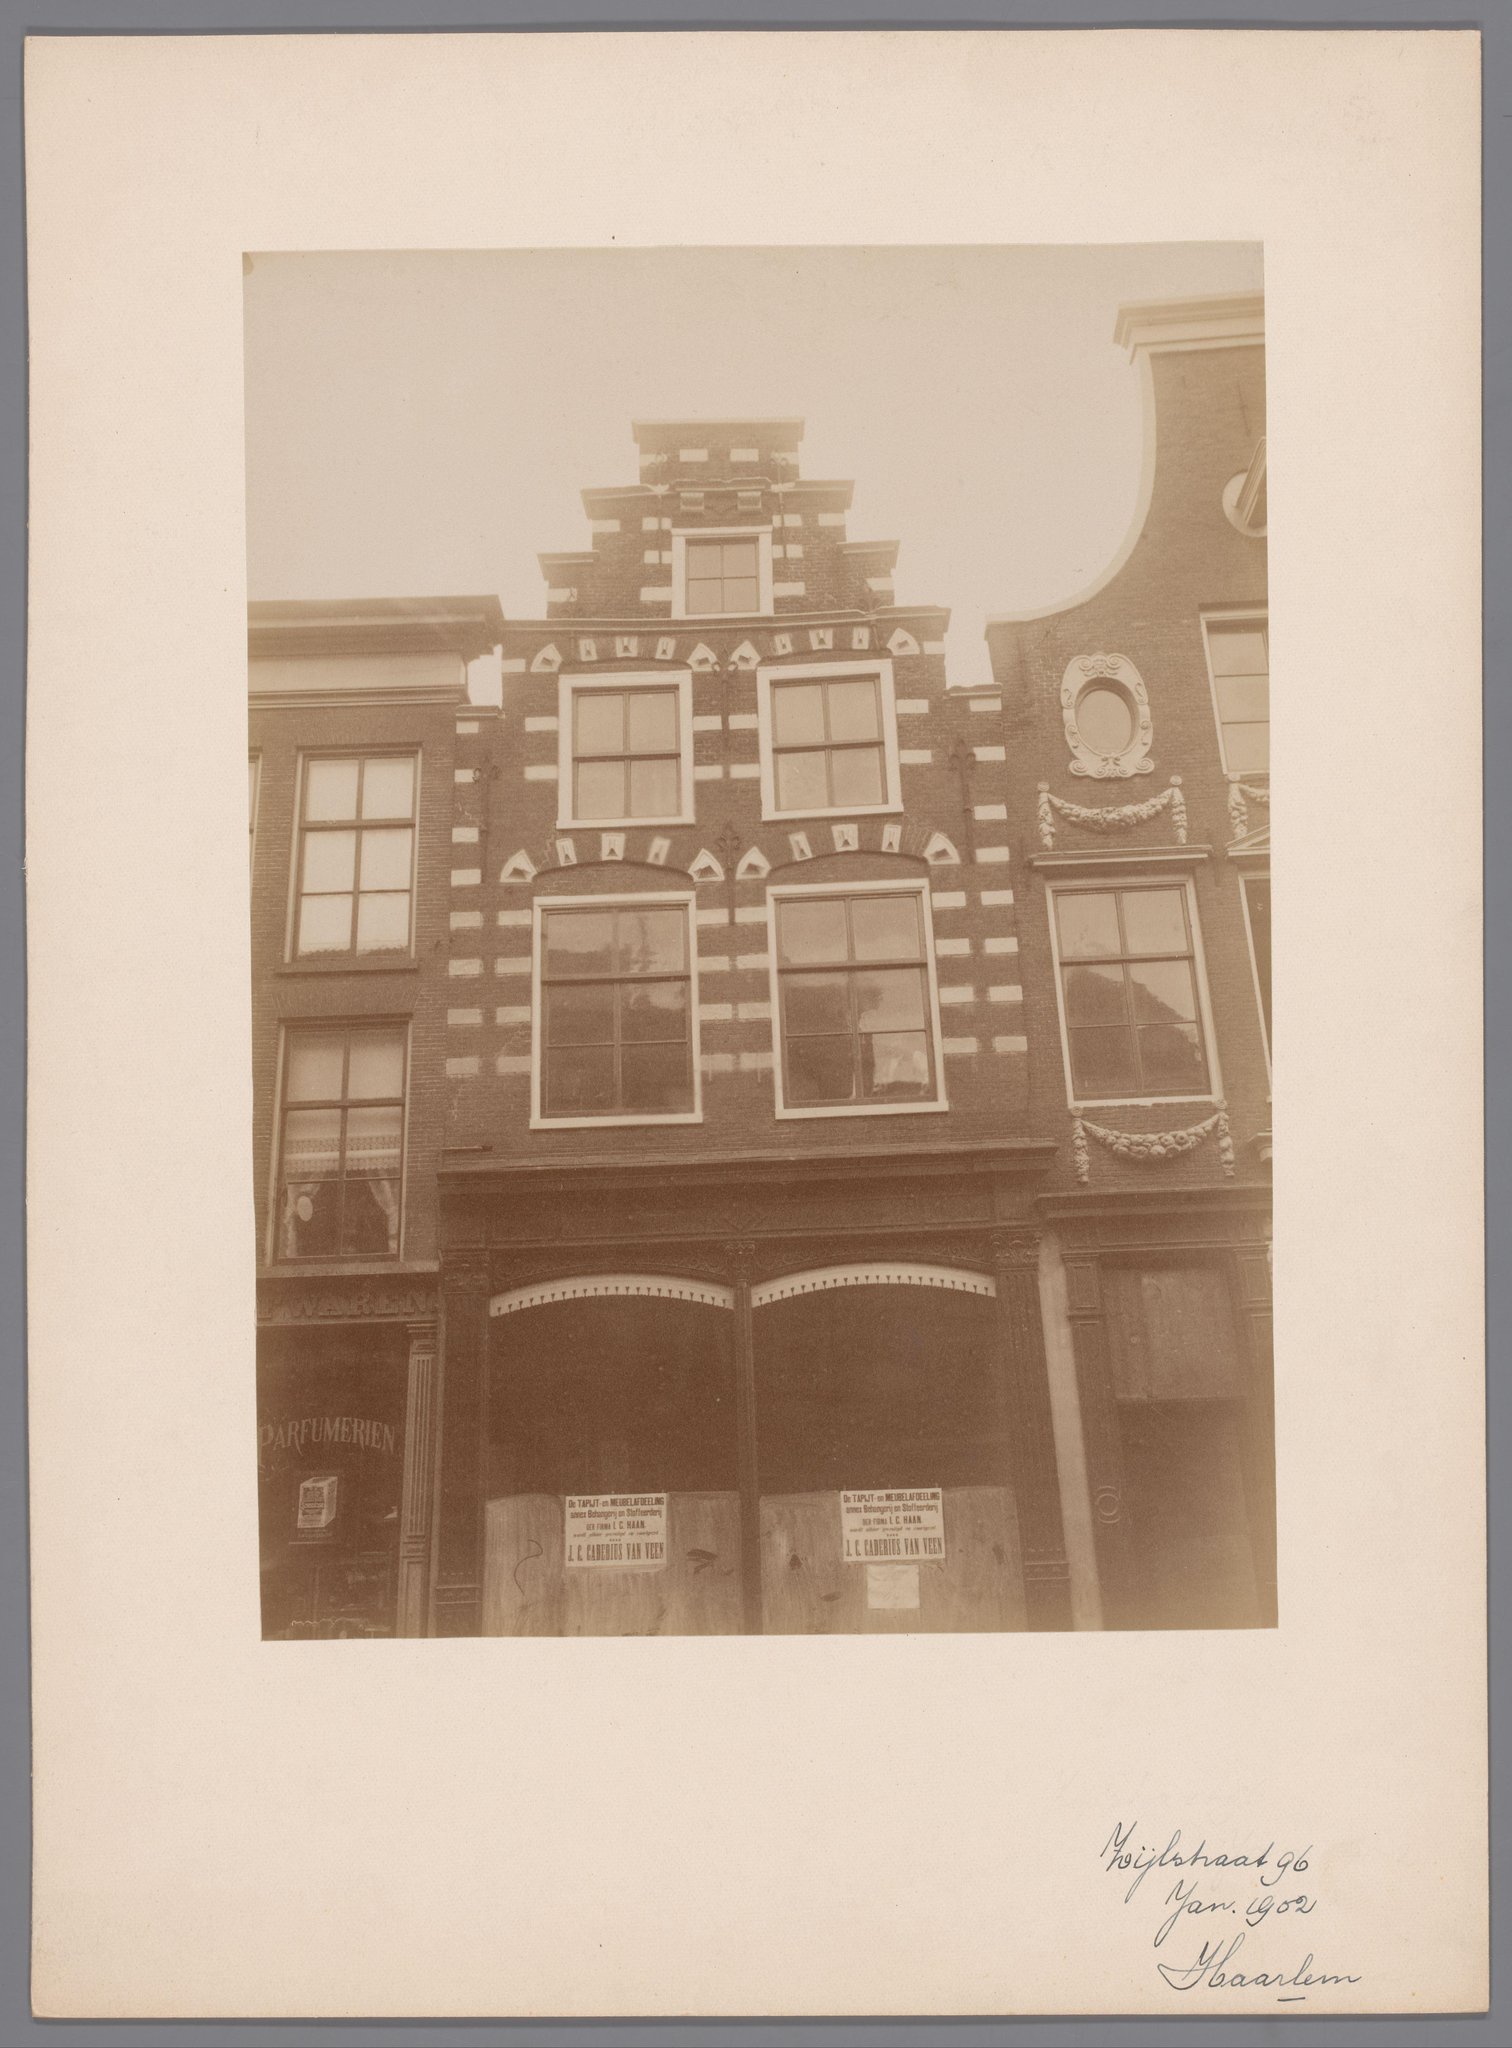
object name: photograph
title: Façade van Zijlstraat 96 te Haarlem tijdens de verbouwing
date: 1902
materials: cardboard, photographic support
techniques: albumen print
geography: zijlstraat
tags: shop, store, façade (of house or building)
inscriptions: annotation: ‘Haarlem (N.H.)/ Zijlstraat N96/ [...]/ Jan 1902’, annotation: ‘Zijlstraat 96/ Jan. 1902/ Haarlem’